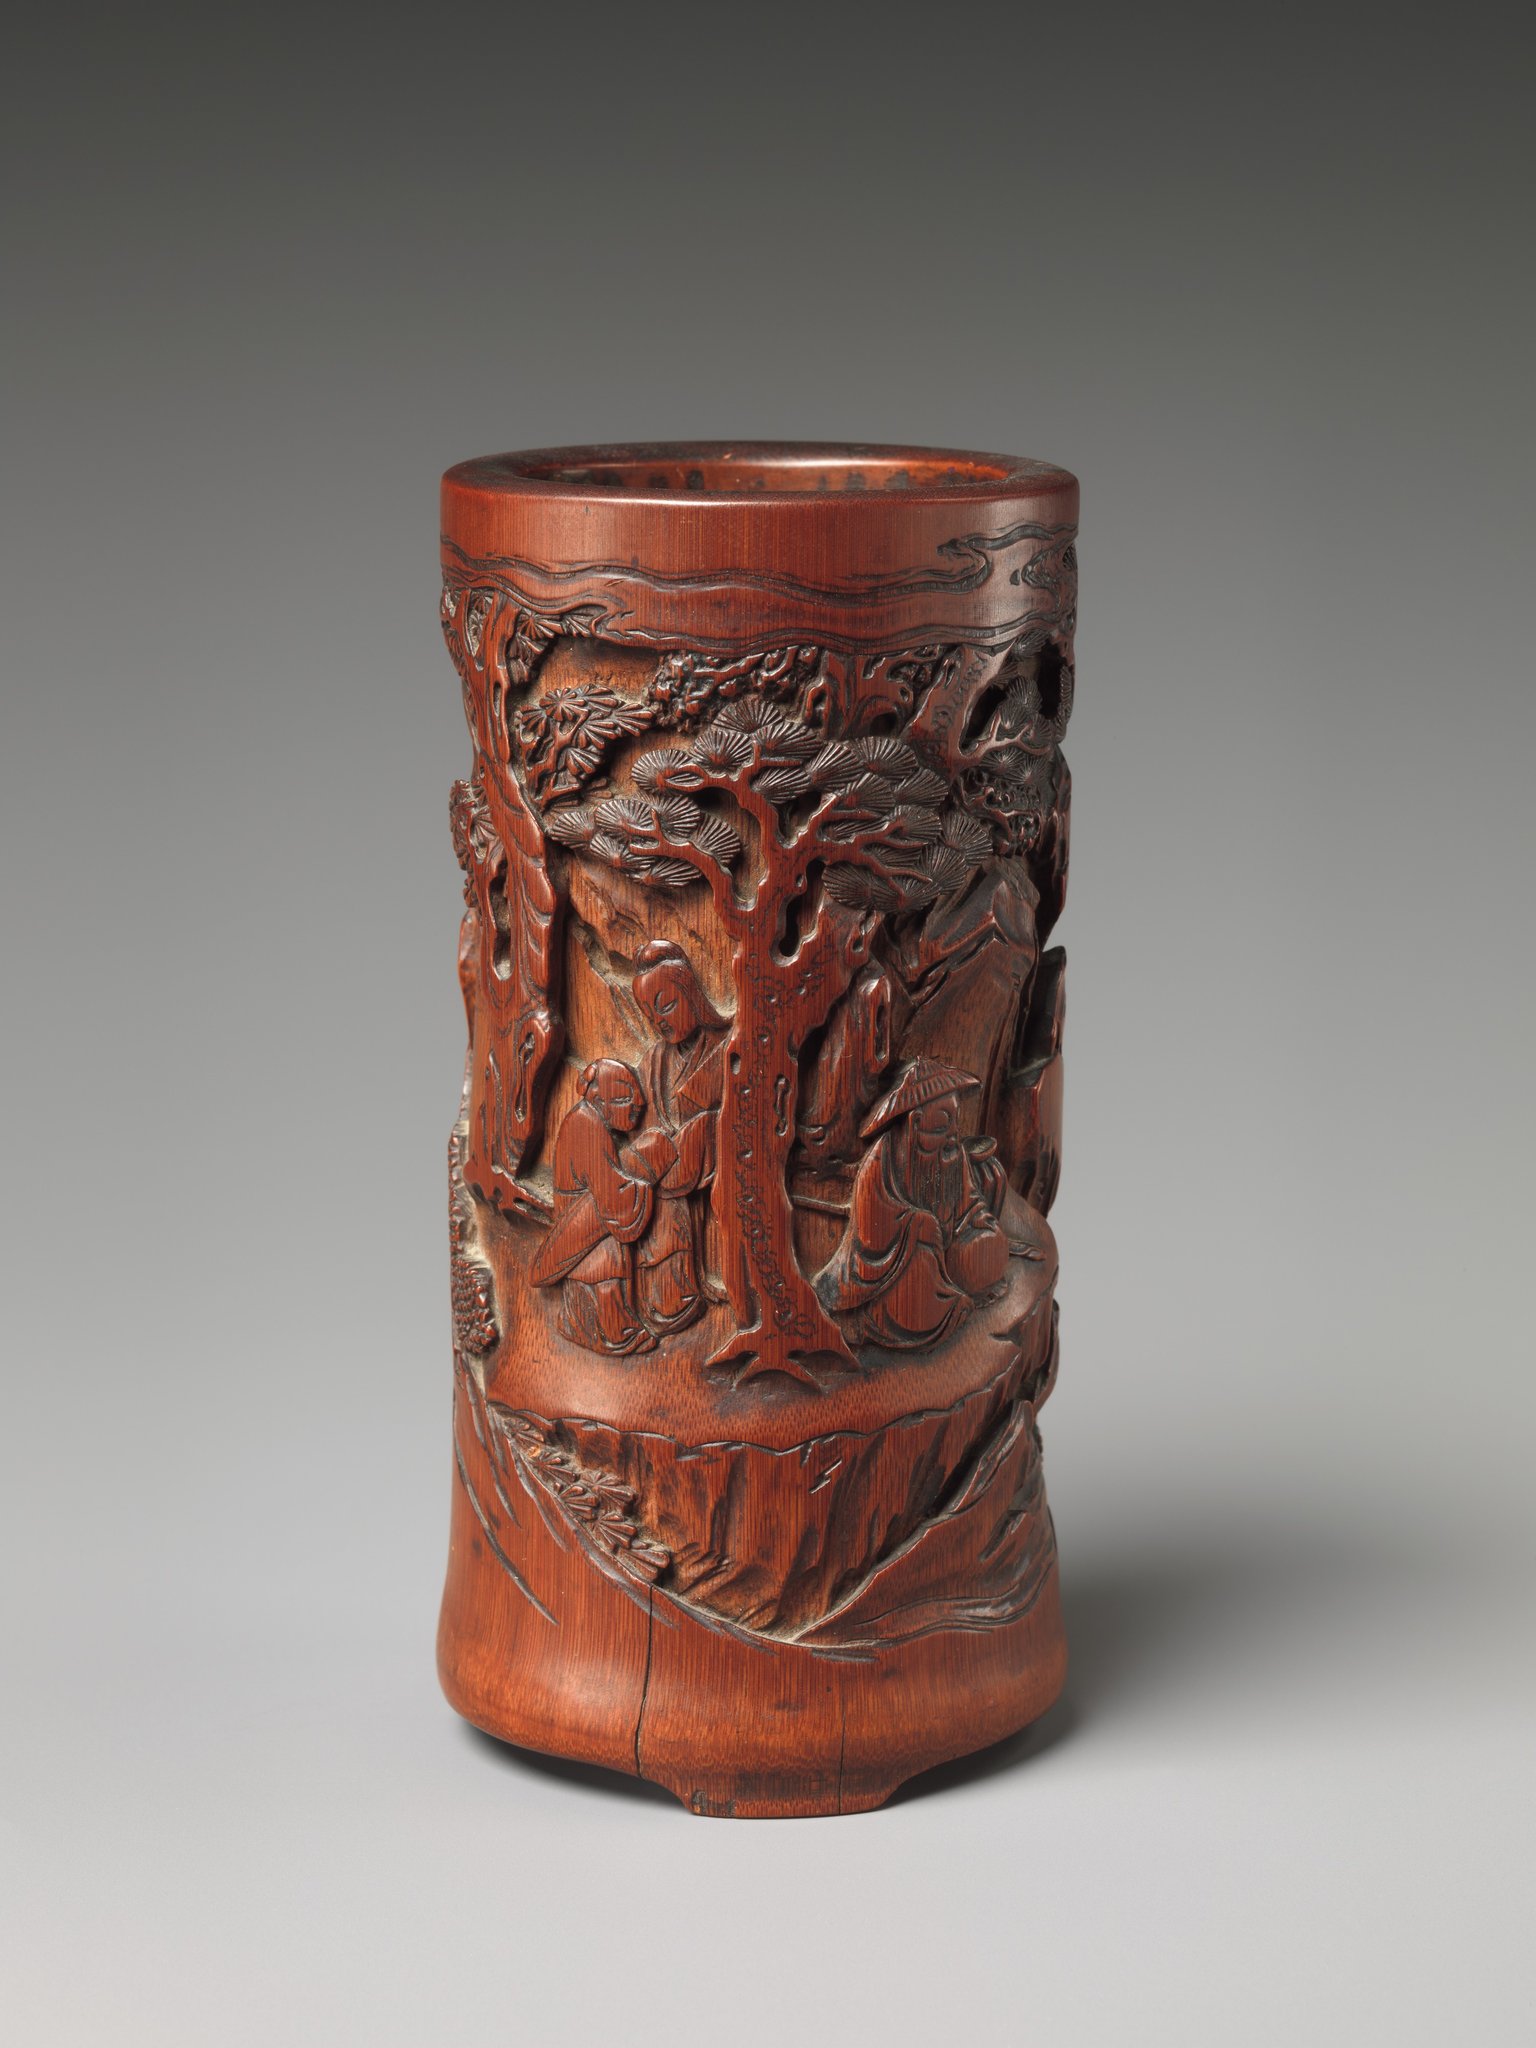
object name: brush holder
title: Brush Holder with Fisherman and Traveler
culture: chinese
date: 1801-1900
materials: bamboo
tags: men,trees